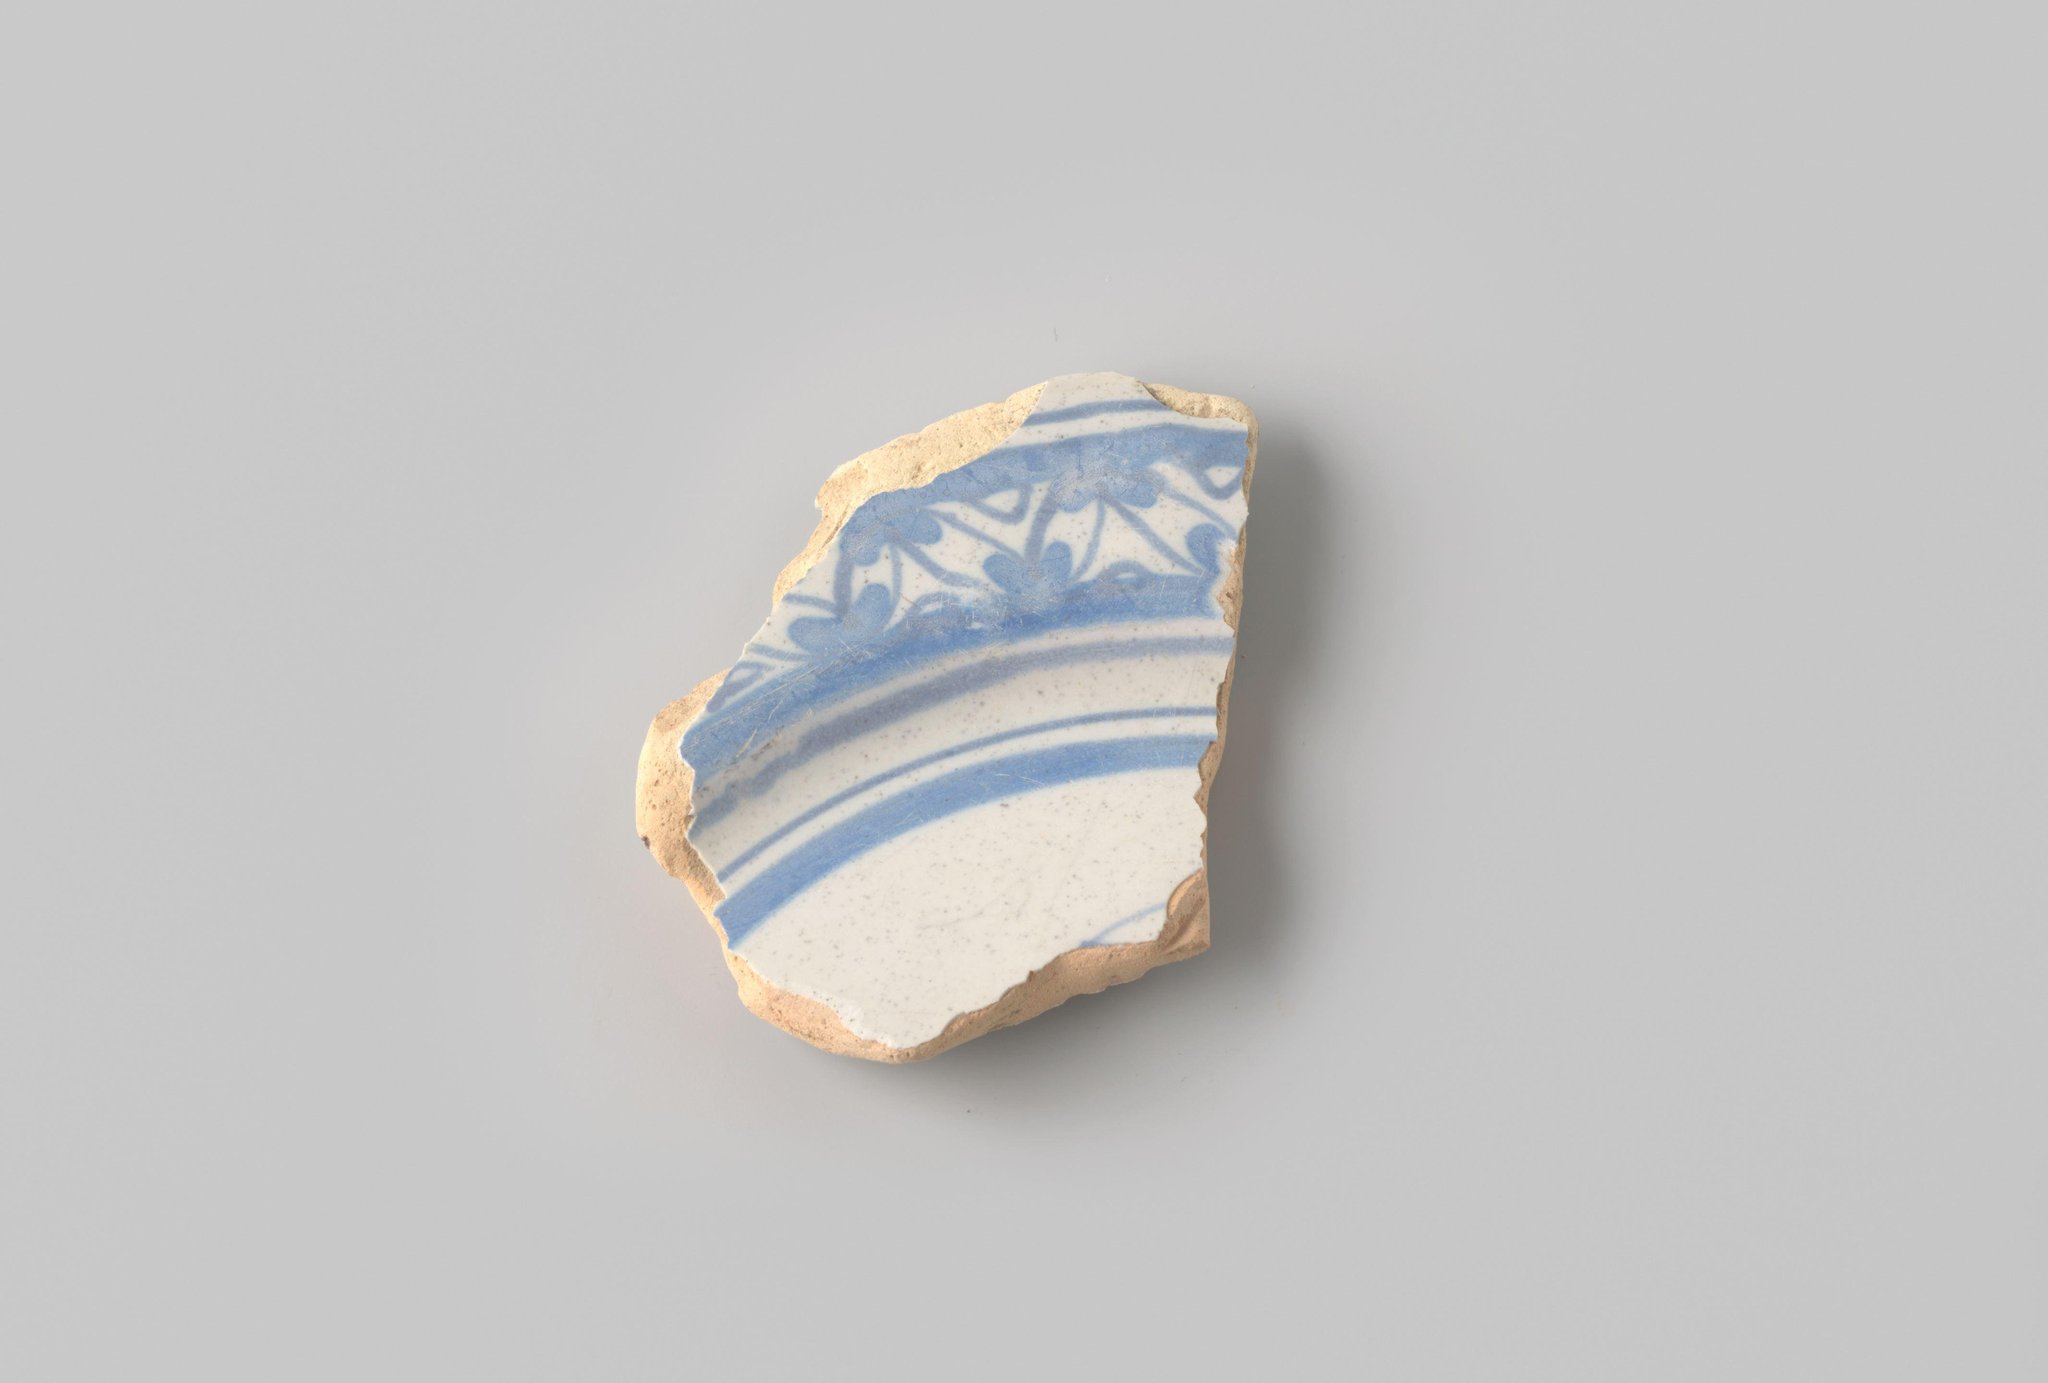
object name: fragment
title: Scherf van gelig bakkend aardewerk, voorzien van wit glazuur, aan de voorzijde voorzien van een sierrand in blauw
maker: Anonymous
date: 1600-1650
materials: earthenware, glaze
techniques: maiolica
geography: northern netherlands